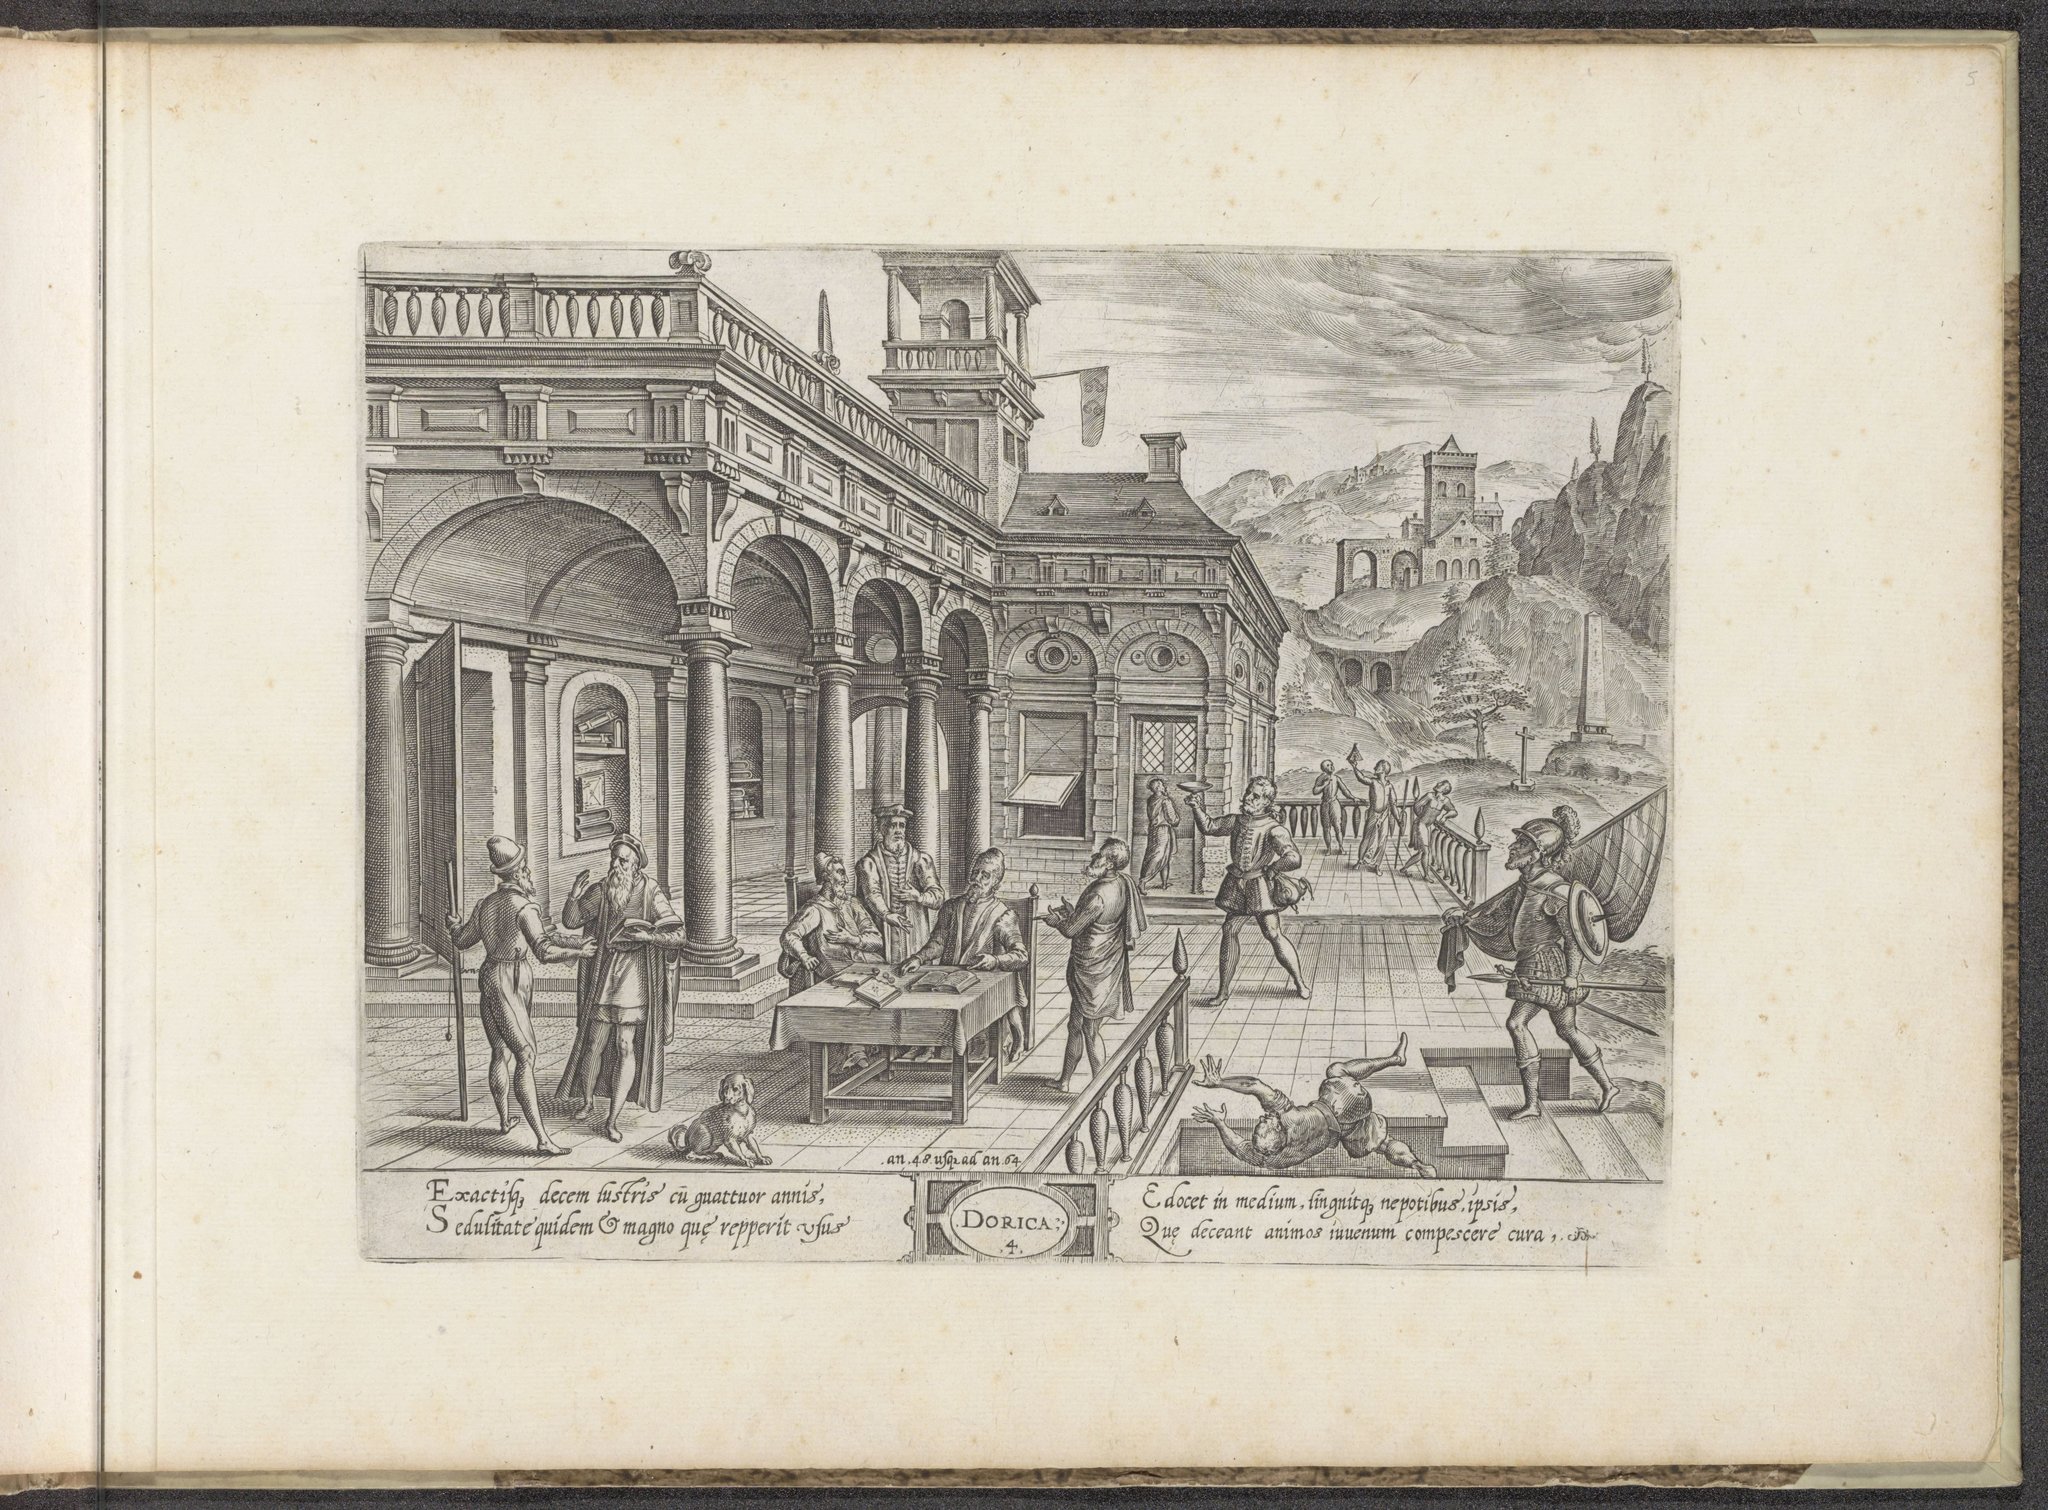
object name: print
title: an 48 usq[ue] ad an 64 / 4. Dorica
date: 1577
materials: paper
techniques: engraving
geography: antwerp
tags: eyeglasses, spectacles, adult woman, reading, doric order ~ architecture, adult man, book - mm - book open, old man, debate, discussion (~ meeting)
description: Oudere mannen zijn in gesprek op het terras voor een huis, gebouwd in de Dorische orde. In de nissen van het huis staan boeken. Een man valt van de trap die naar het terras leidt. Een krijgsman komt de trap op. Rechts op de achtergrond staan een obelisk en een kruis. Uit de toren van het huis een vlag met daarop twee brillen. In de marge een vierregelige tekst in twee kolommen, in het Latijn. De prent maakt deel uit van een album.